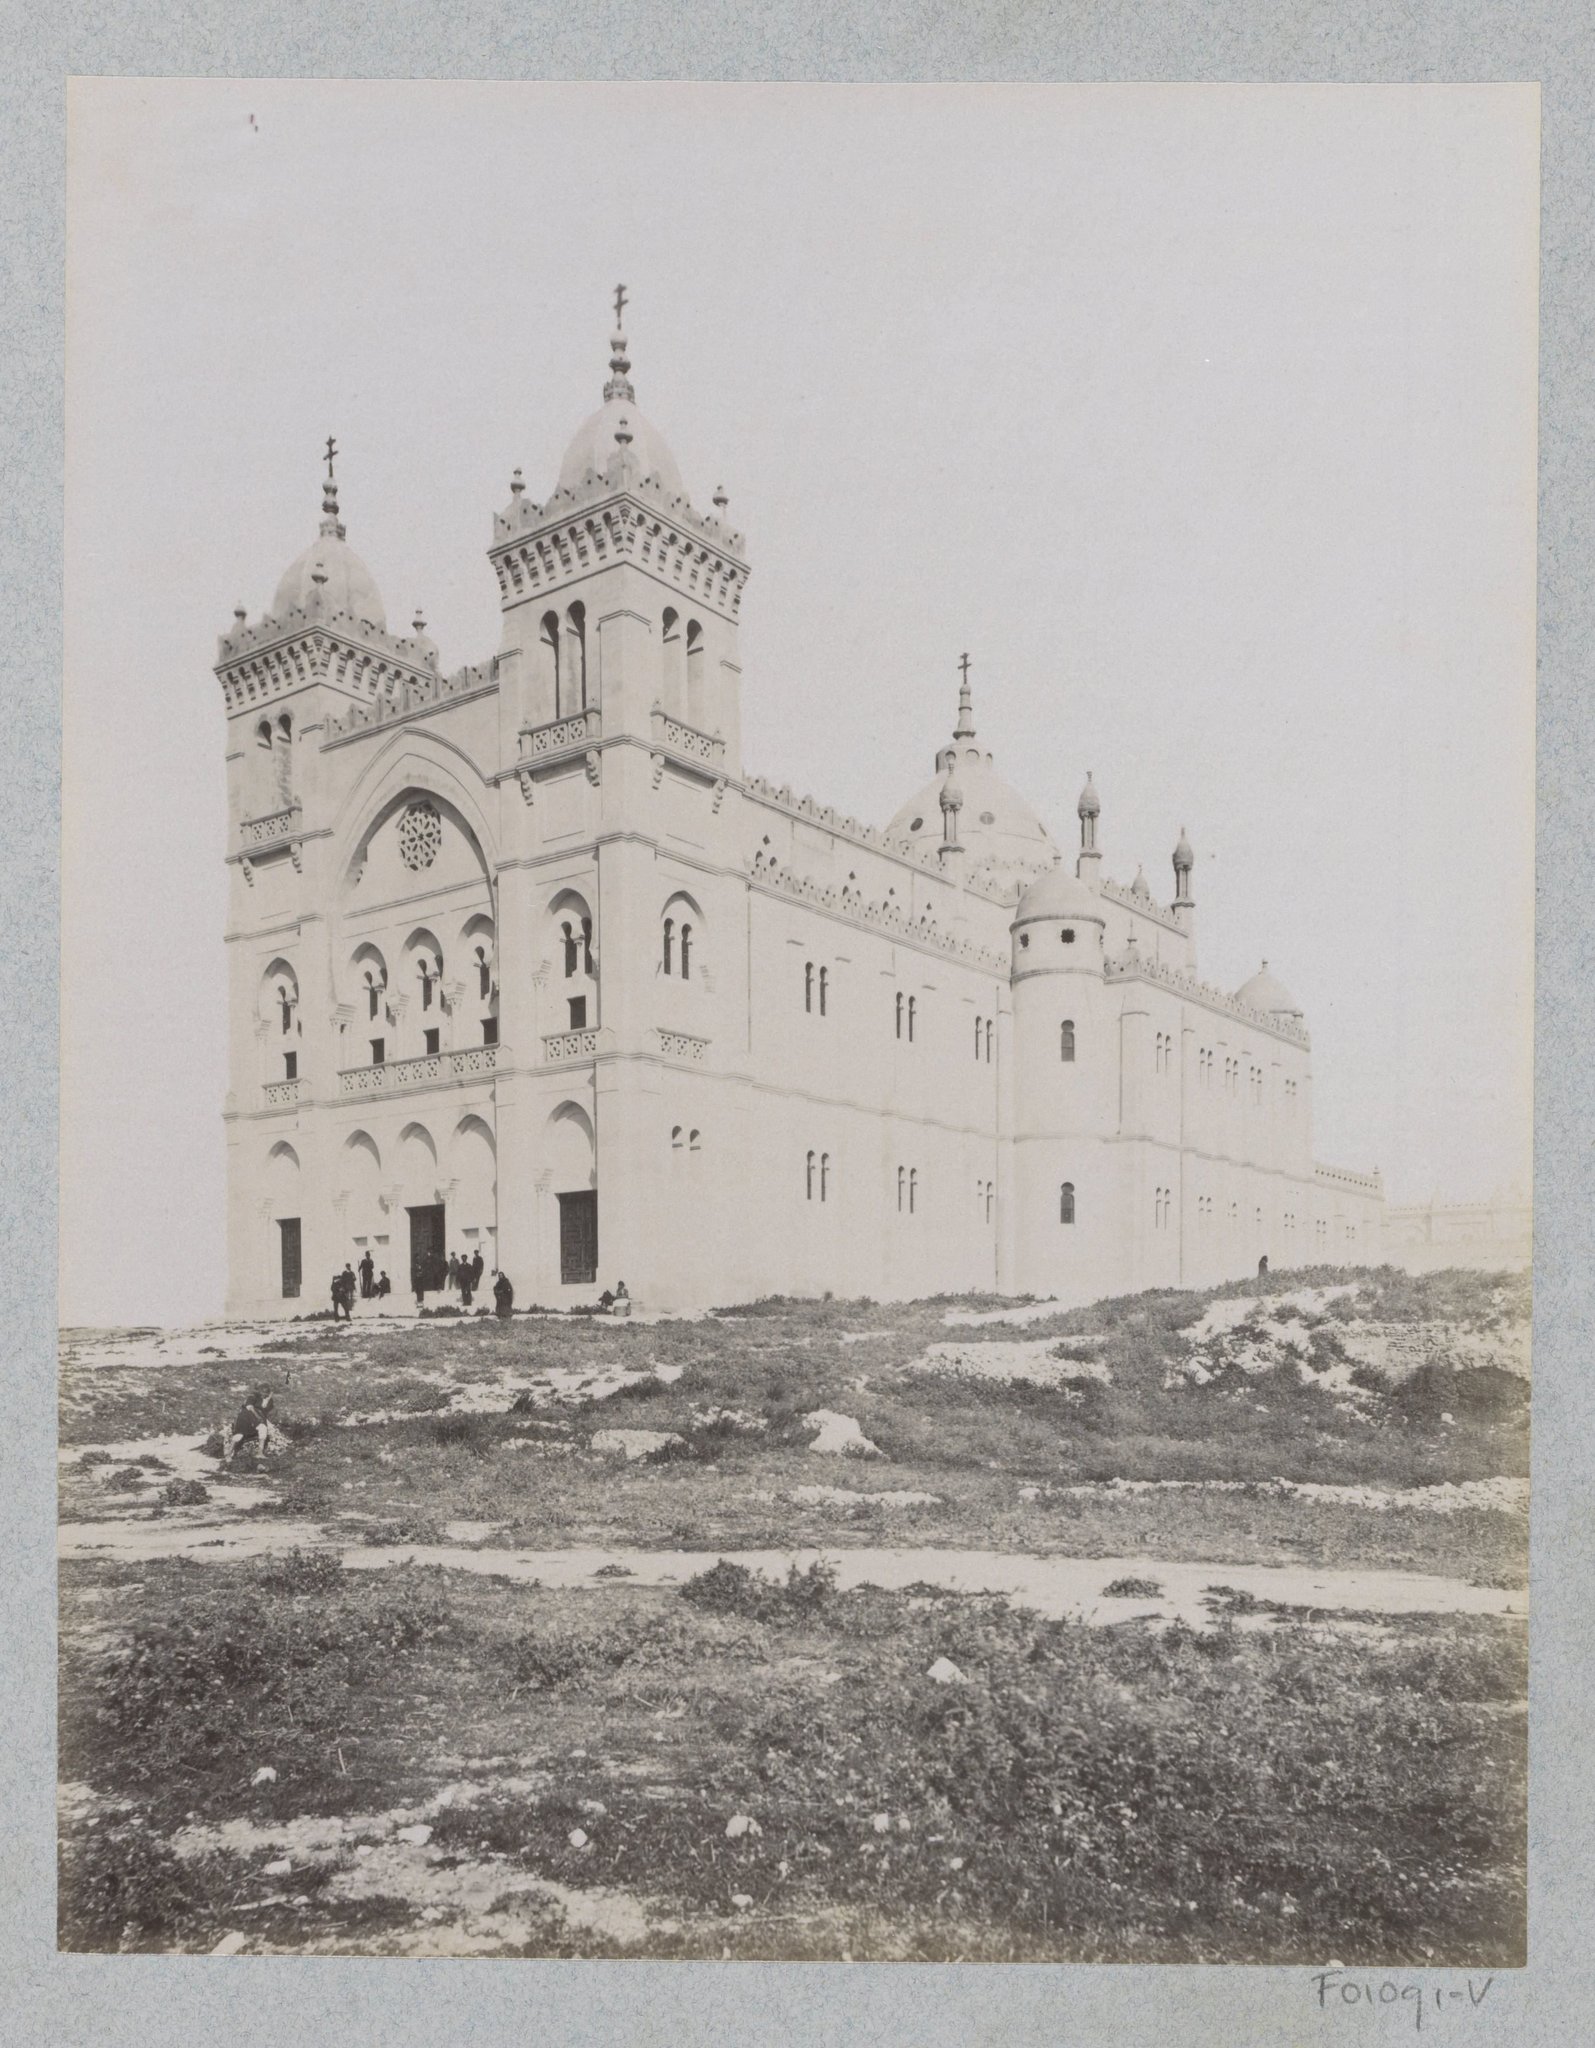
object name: album leaf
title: Exterieur van de kloosterkerk van de Witte Paters in Carthago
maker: Anonymous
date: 1880-1900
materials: paper, photographic support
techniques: albumen print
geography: carthage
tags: church (exterior)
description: Onderdeel van Reisalbum met foto's van bezienswaardigheden in Tunis en Tunesië.